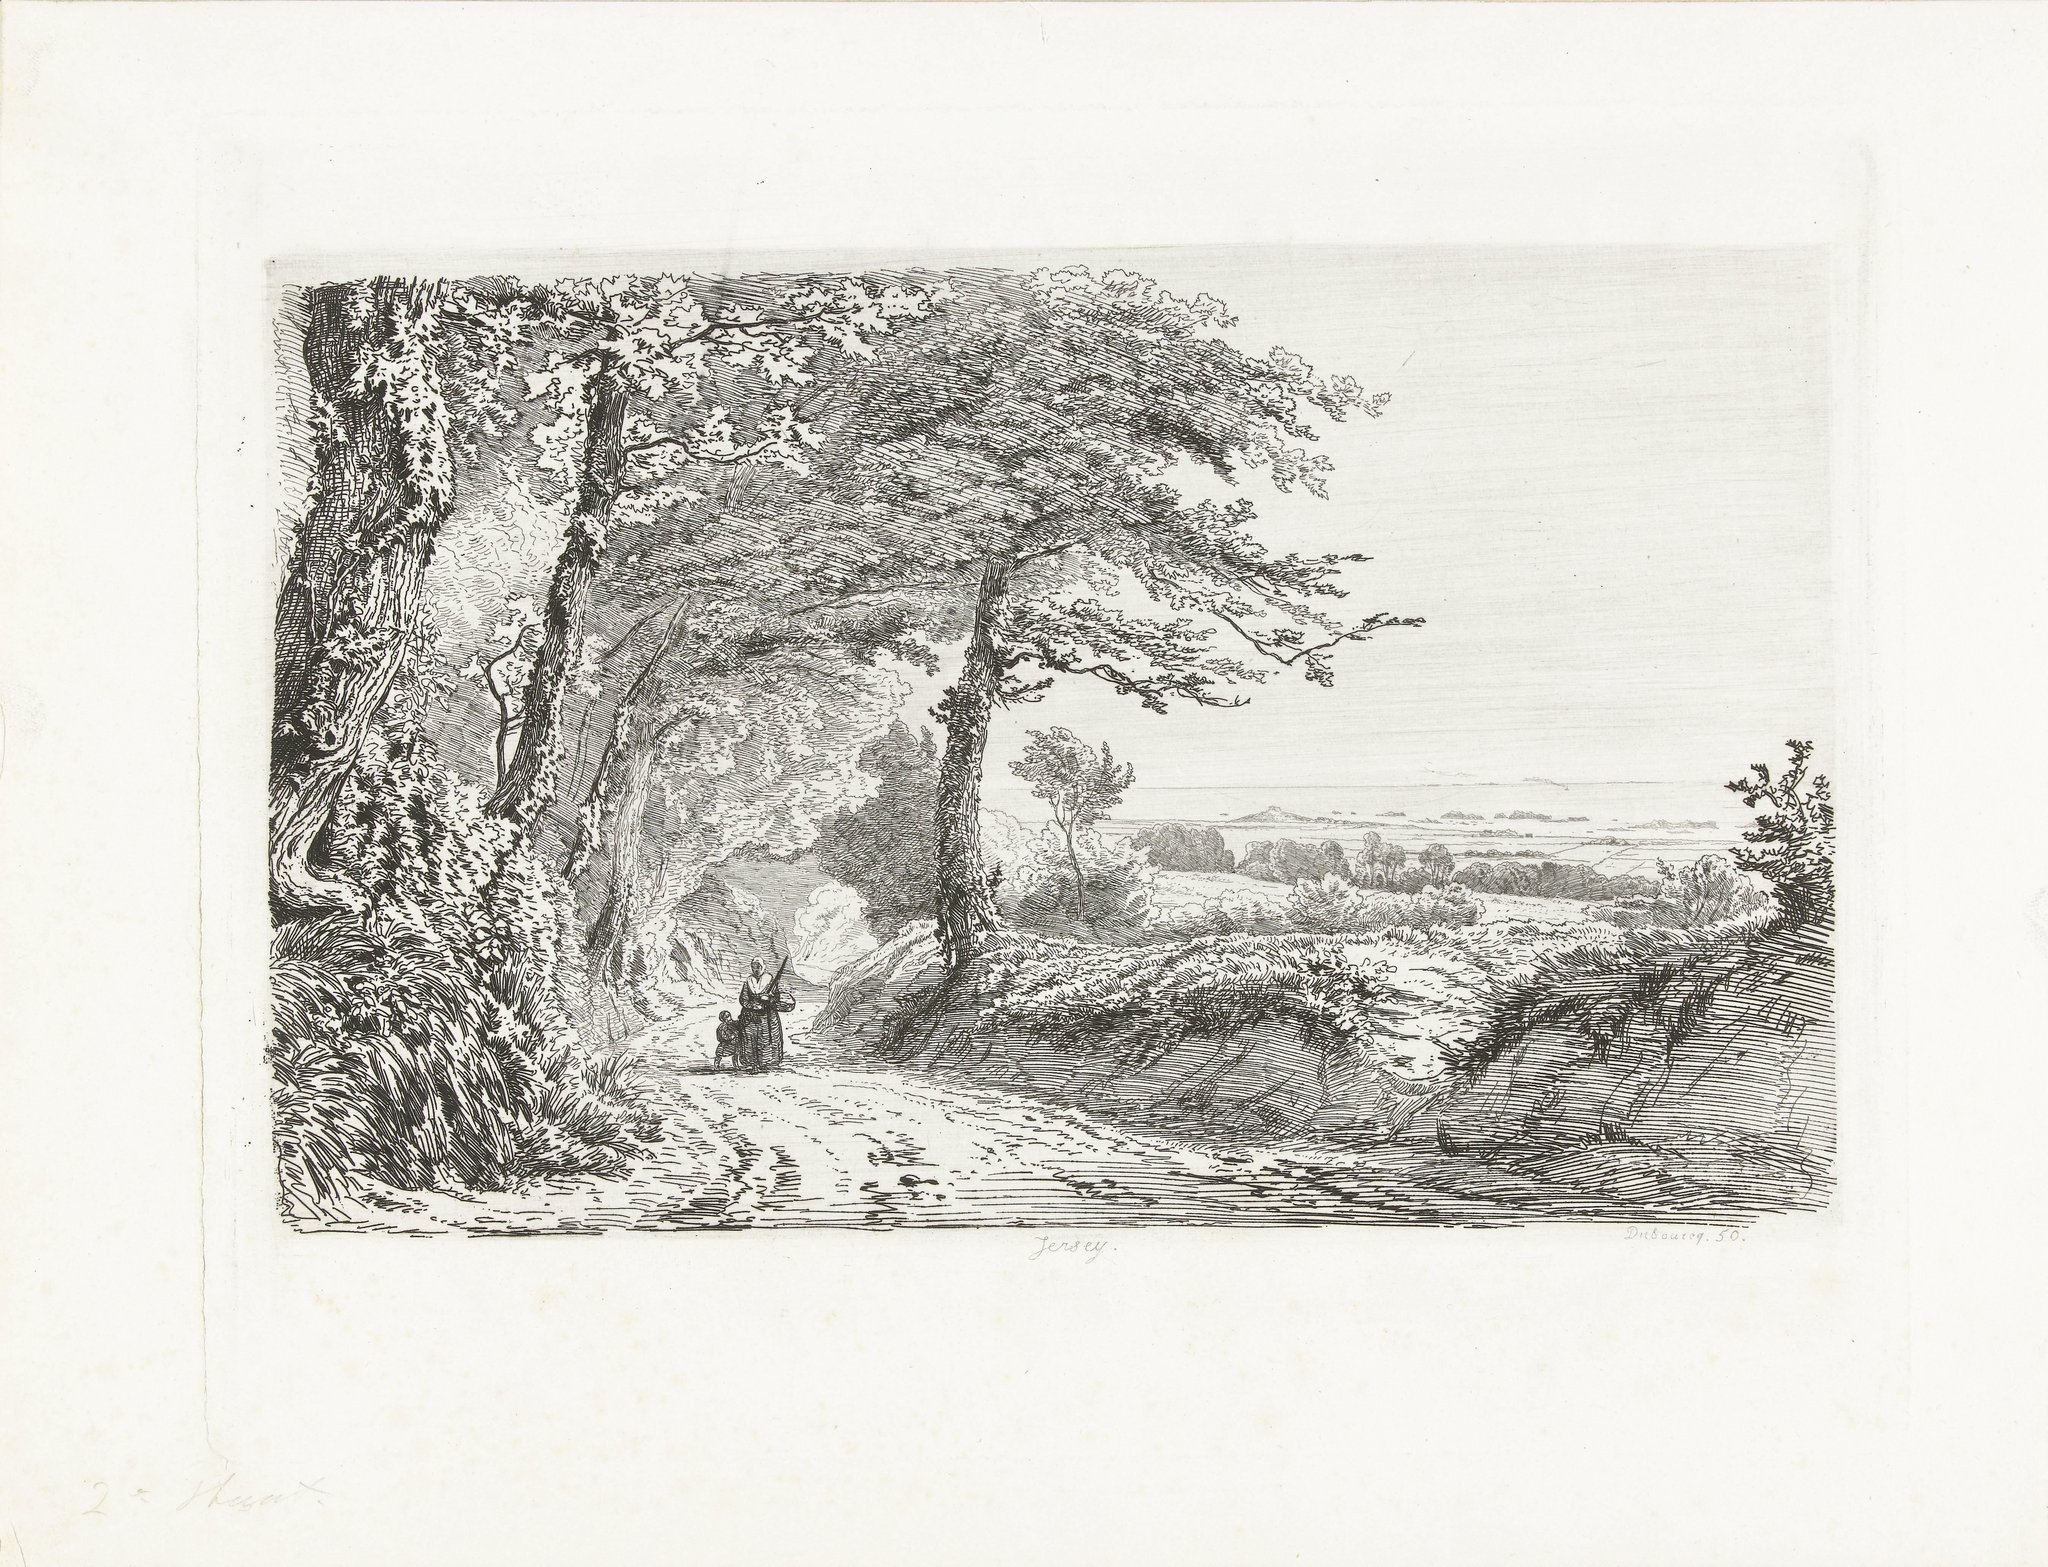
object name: print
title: Zes etsproeven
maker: pierre louis dubourcq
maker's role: draughtsman, painter, print maker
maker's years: 1815-1873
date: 1850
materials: paper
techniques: etching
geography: netherlands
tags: forest path or lane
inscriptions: collector's mark: Lugt 2228